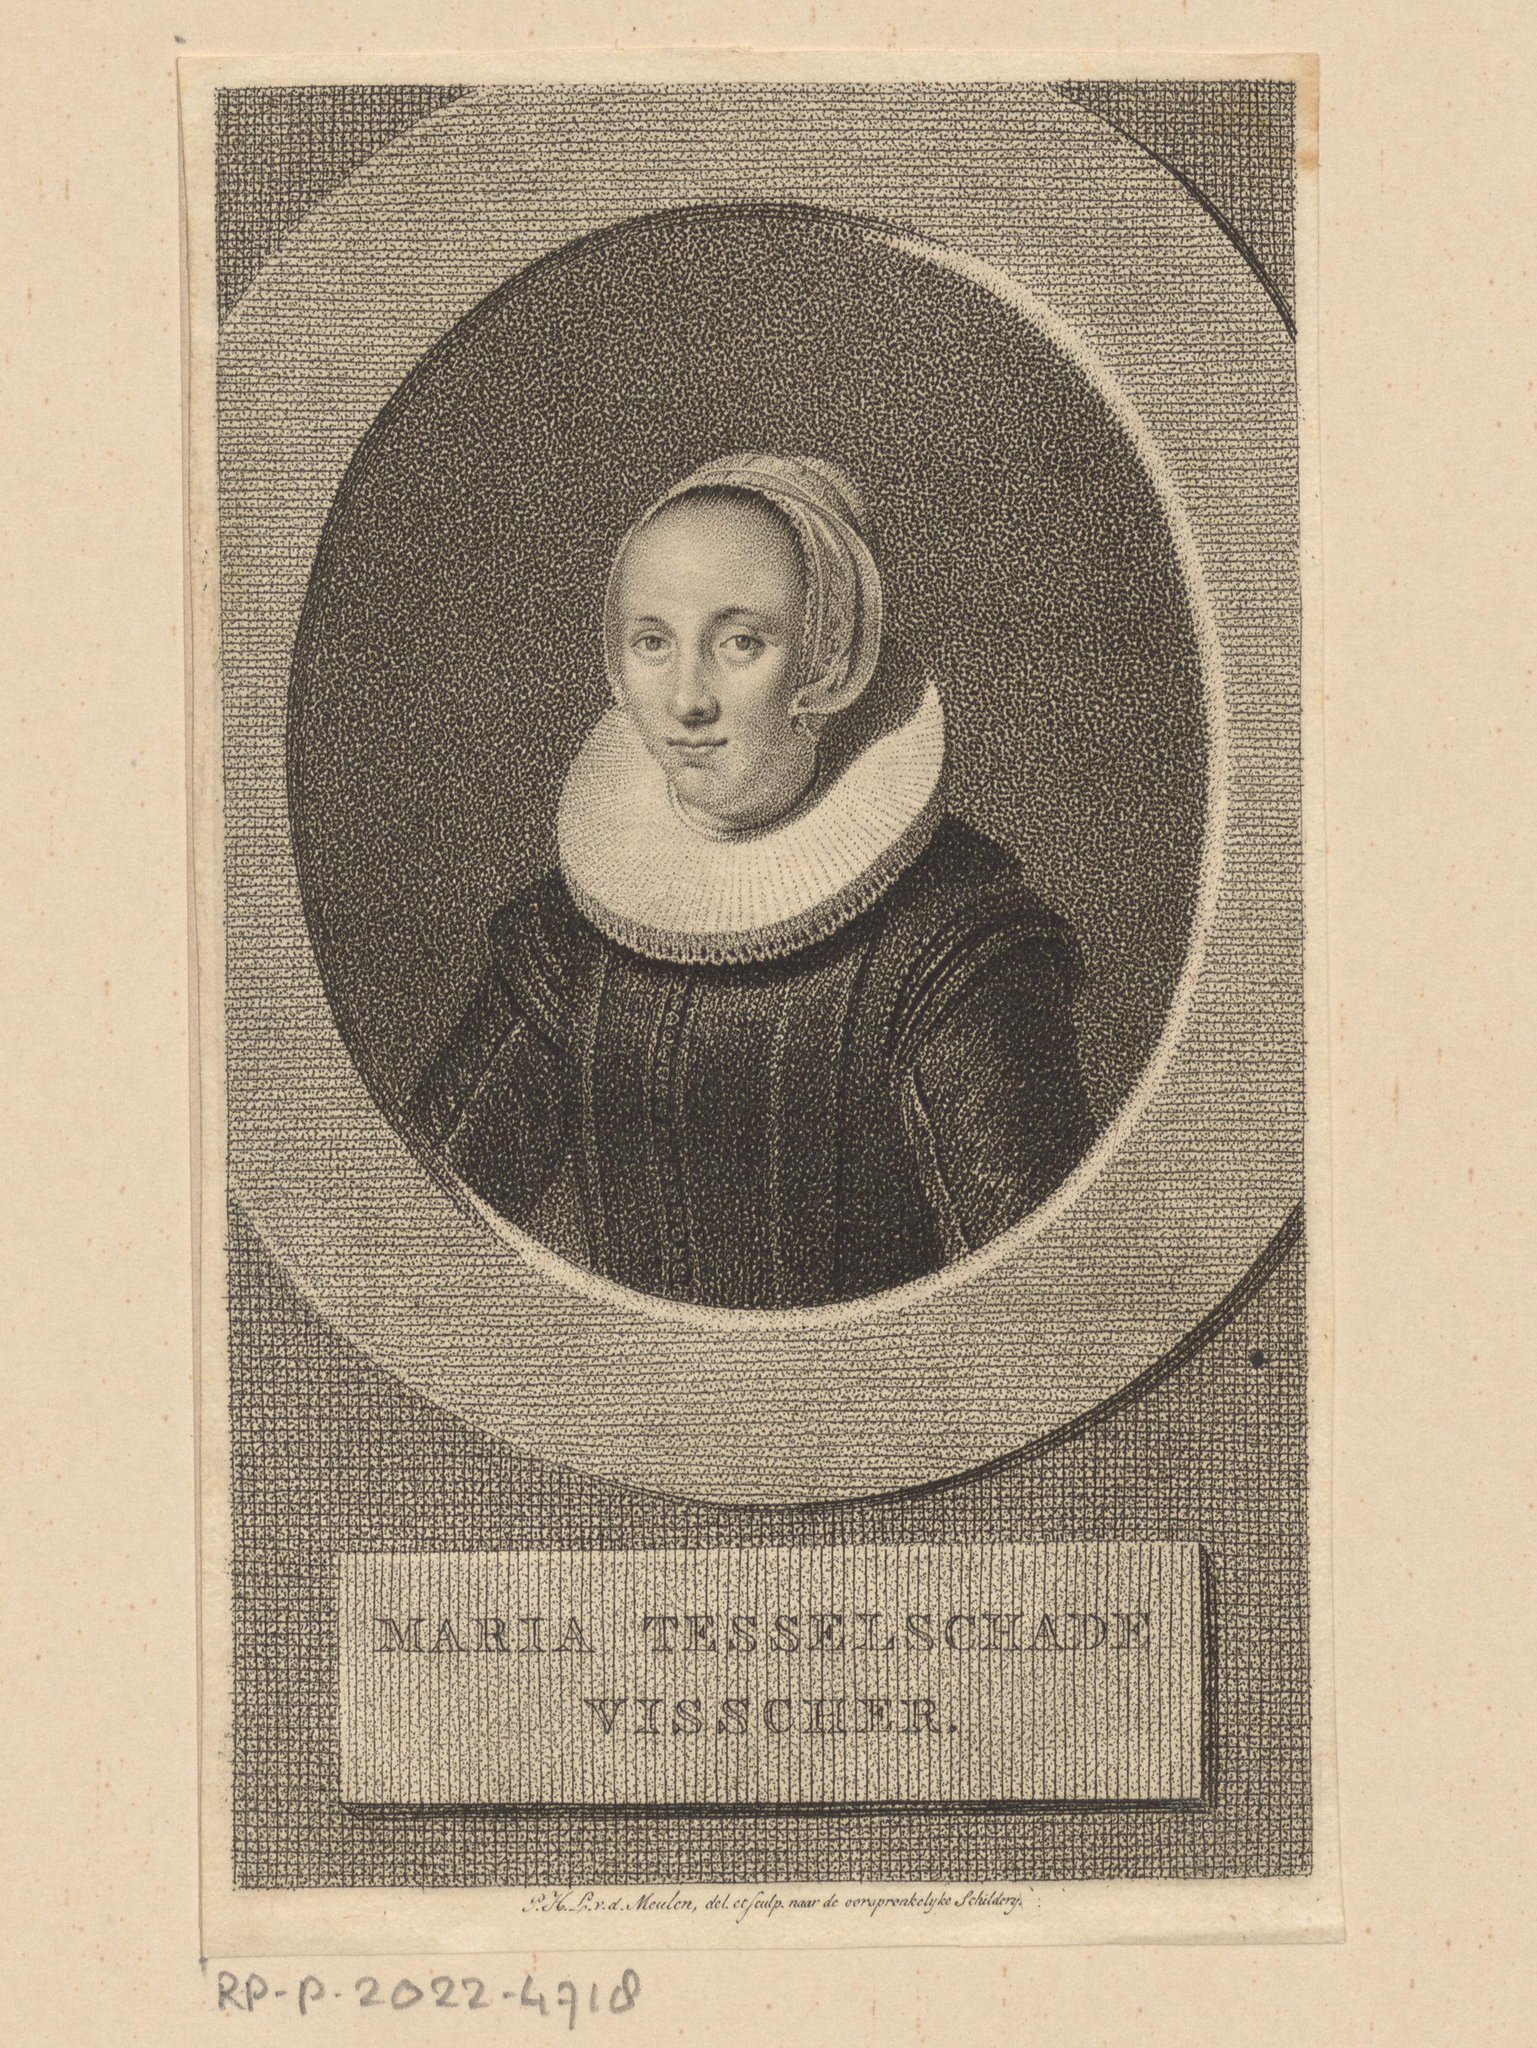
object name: print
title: Maria Tesselschade Visscher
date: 1808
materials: paper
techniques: etching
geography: amsterdam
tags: amsterdam, maria tesselschade roemers visscher, anonymous historical person portrayed alone - bb - woman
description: Prent waarschijnlijk uit: Scheltema, Jacobus. Anna en Maria Tesselschade, de dochters van Roemer Visscher. Amsterdam: J.W. Ijntema en Comp., 1808.